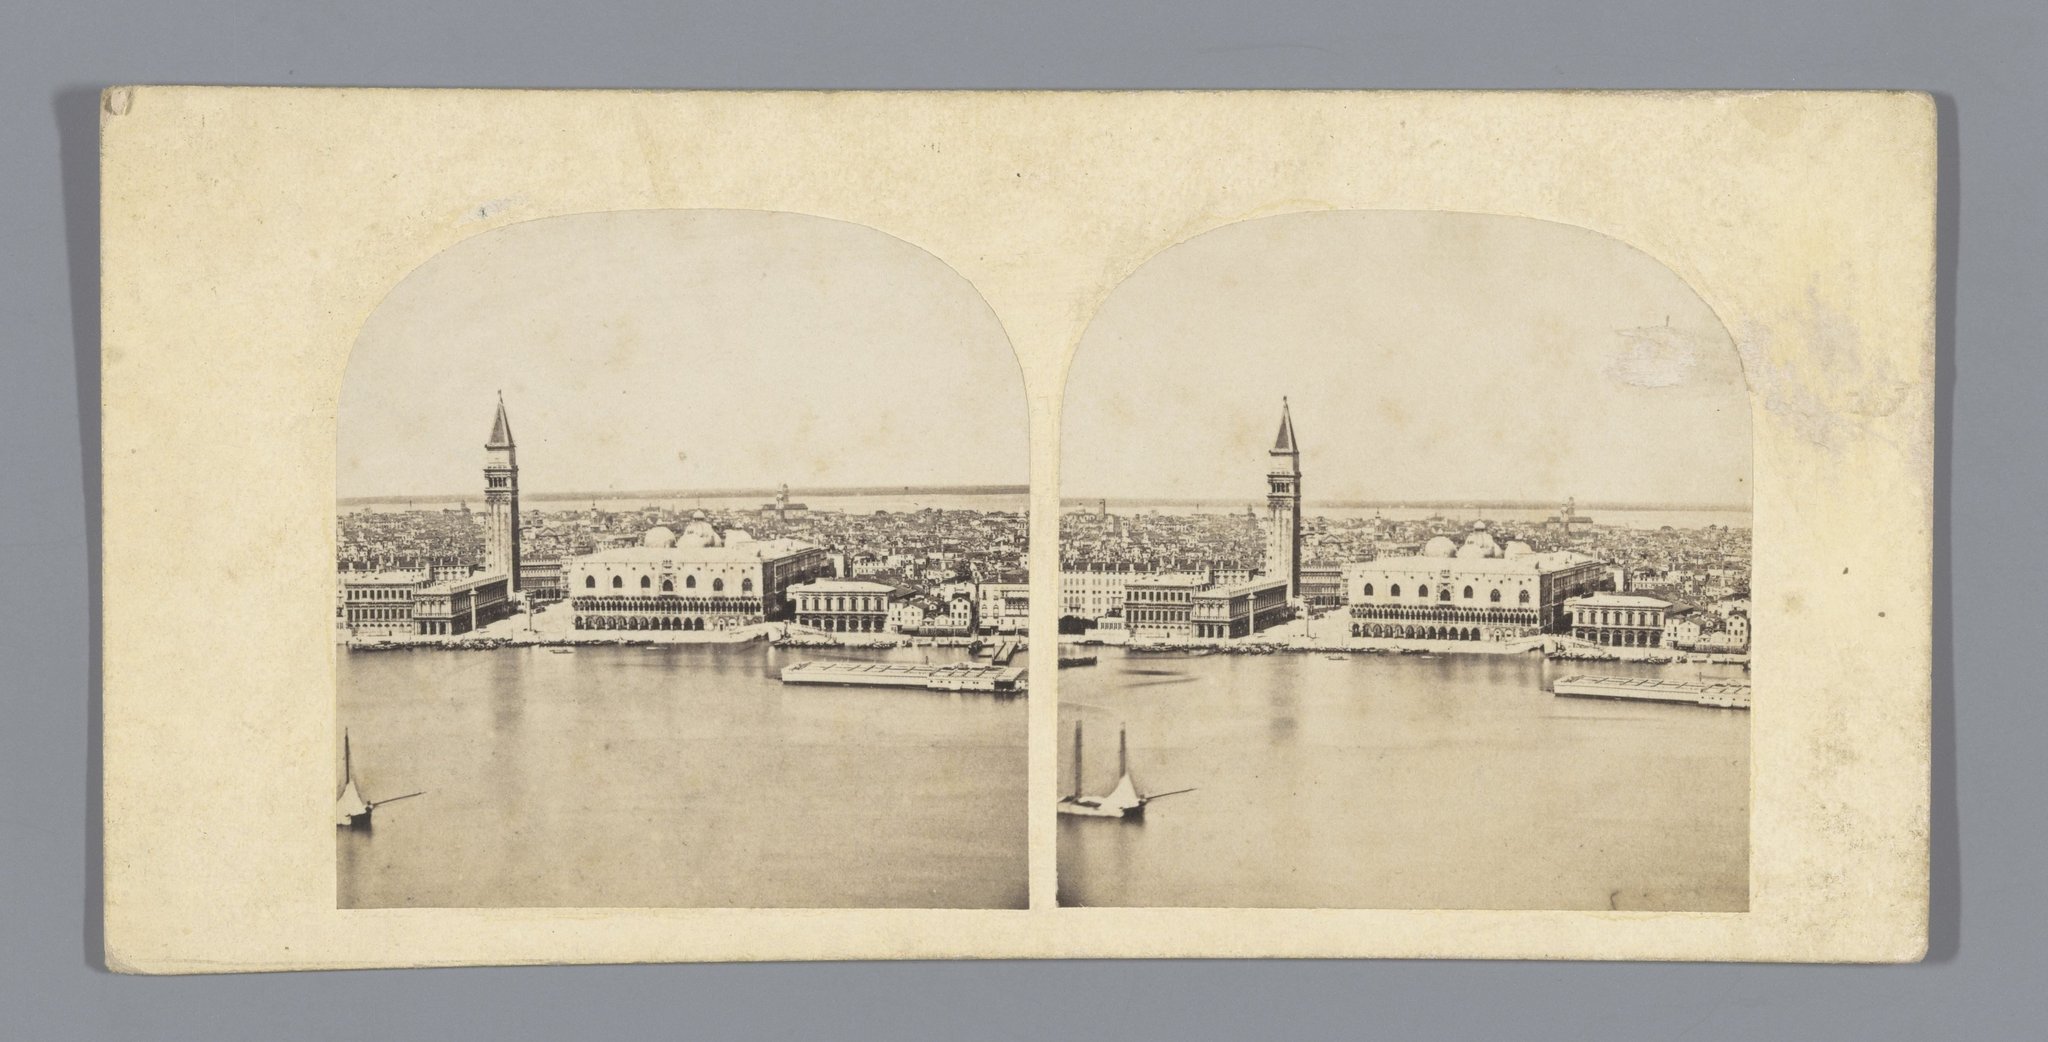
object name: stereograph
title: Gezicht op Venetië, gezien vanaf de klokkentoren van de Basilica di San Giorgio Maggiore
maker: Anonymous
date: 1850-1880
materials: cardboard, photographic support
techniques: albumen print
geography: chiesa di san giorgio maggiore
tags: city-view in general; 'veduta', sea, venice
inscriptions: inscription: ‘Panorama de Venise’, name: ‘Stereocopbilder in reicher Auswahl in der Kunsthandlung bon Joh. Heinrigs in Cöln. Hochstrasse No. 152.’